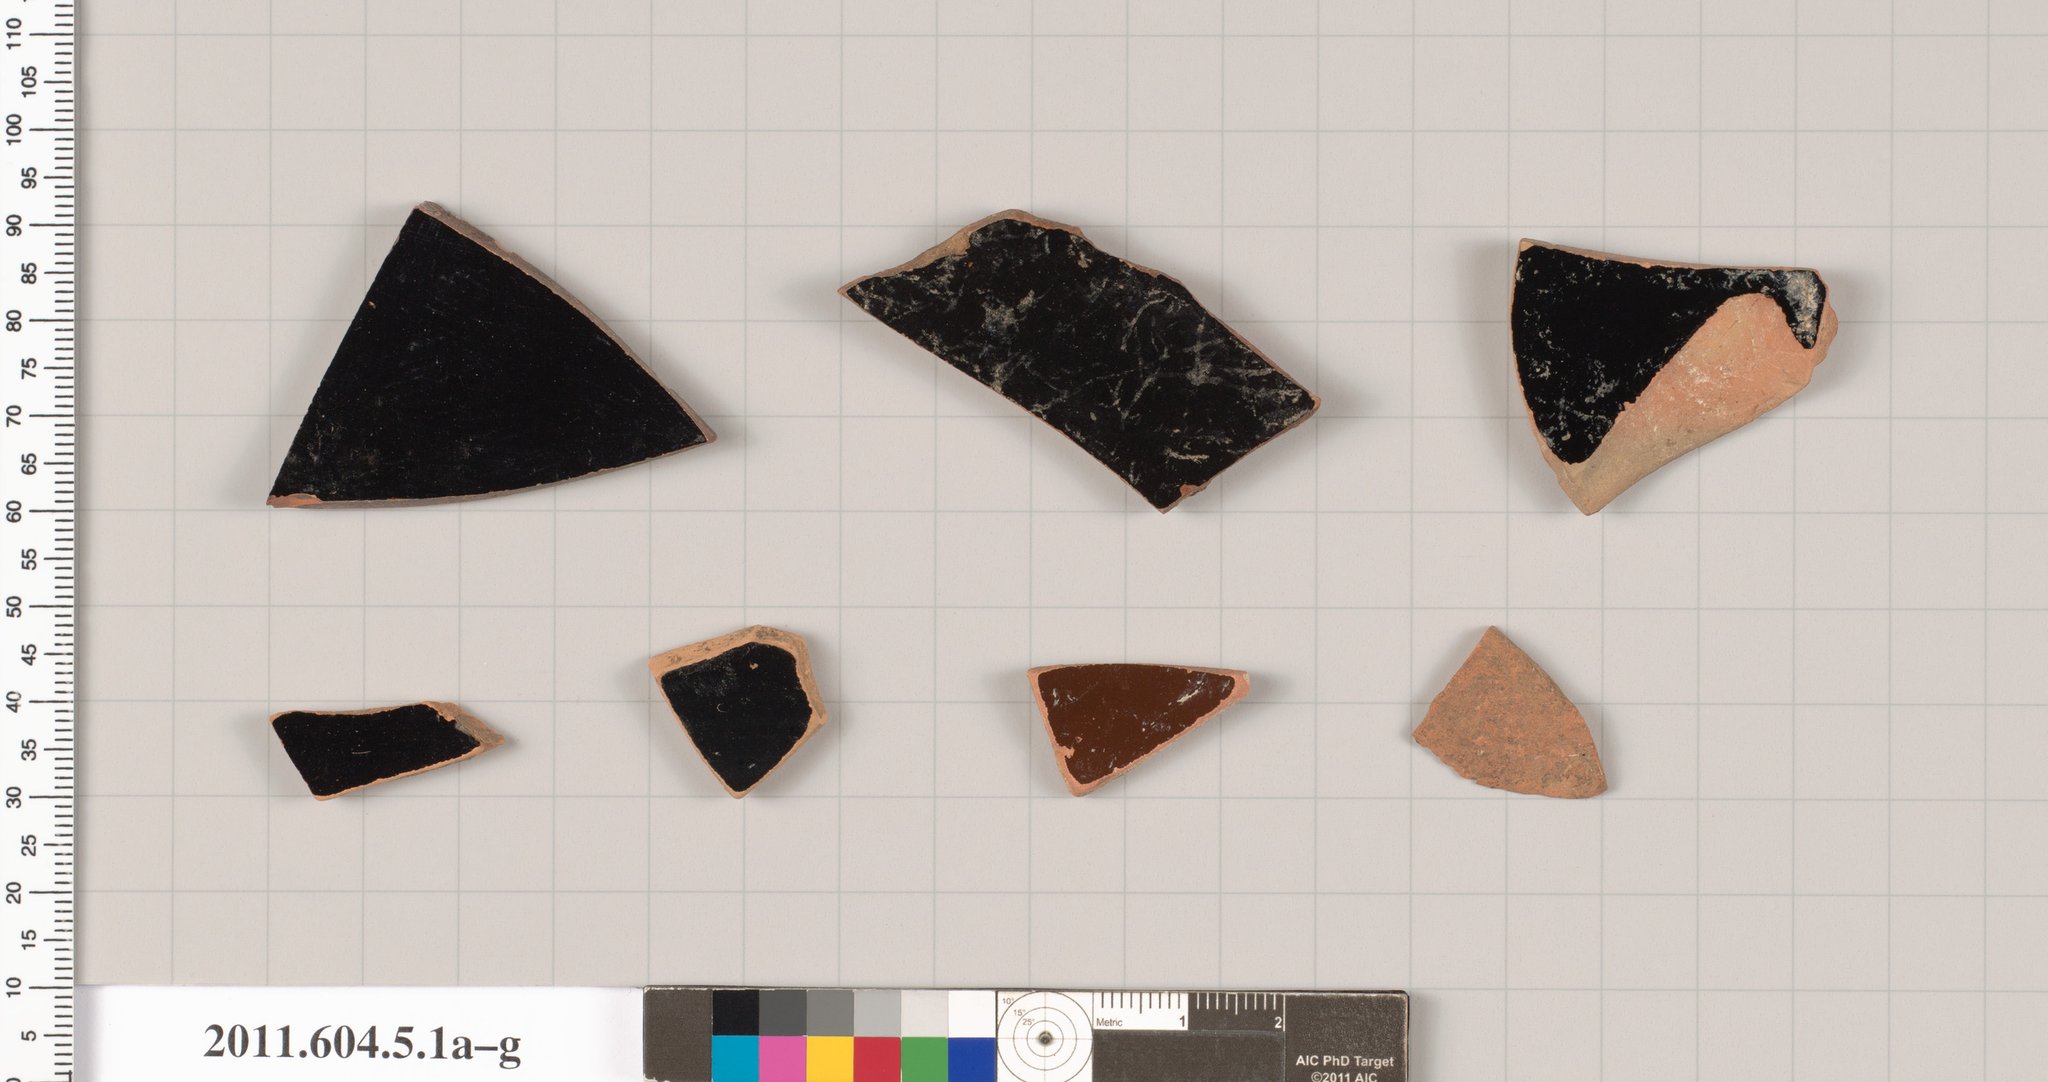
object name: kylix fragment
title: Terracotta fragments of kylikes (drinking cups)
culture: greek, attic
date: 500-401 BCE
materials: terracotta